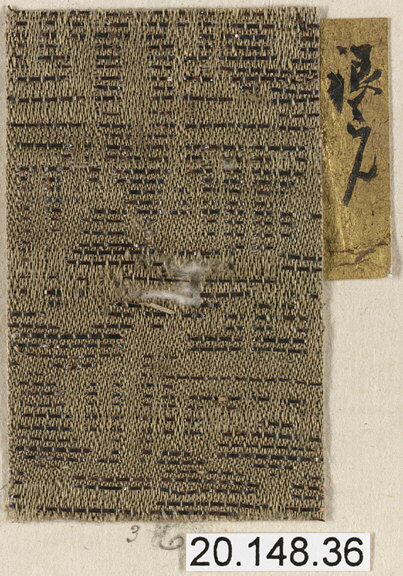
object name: piece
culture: japanese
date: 1401-1500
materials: silk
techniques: compound weave